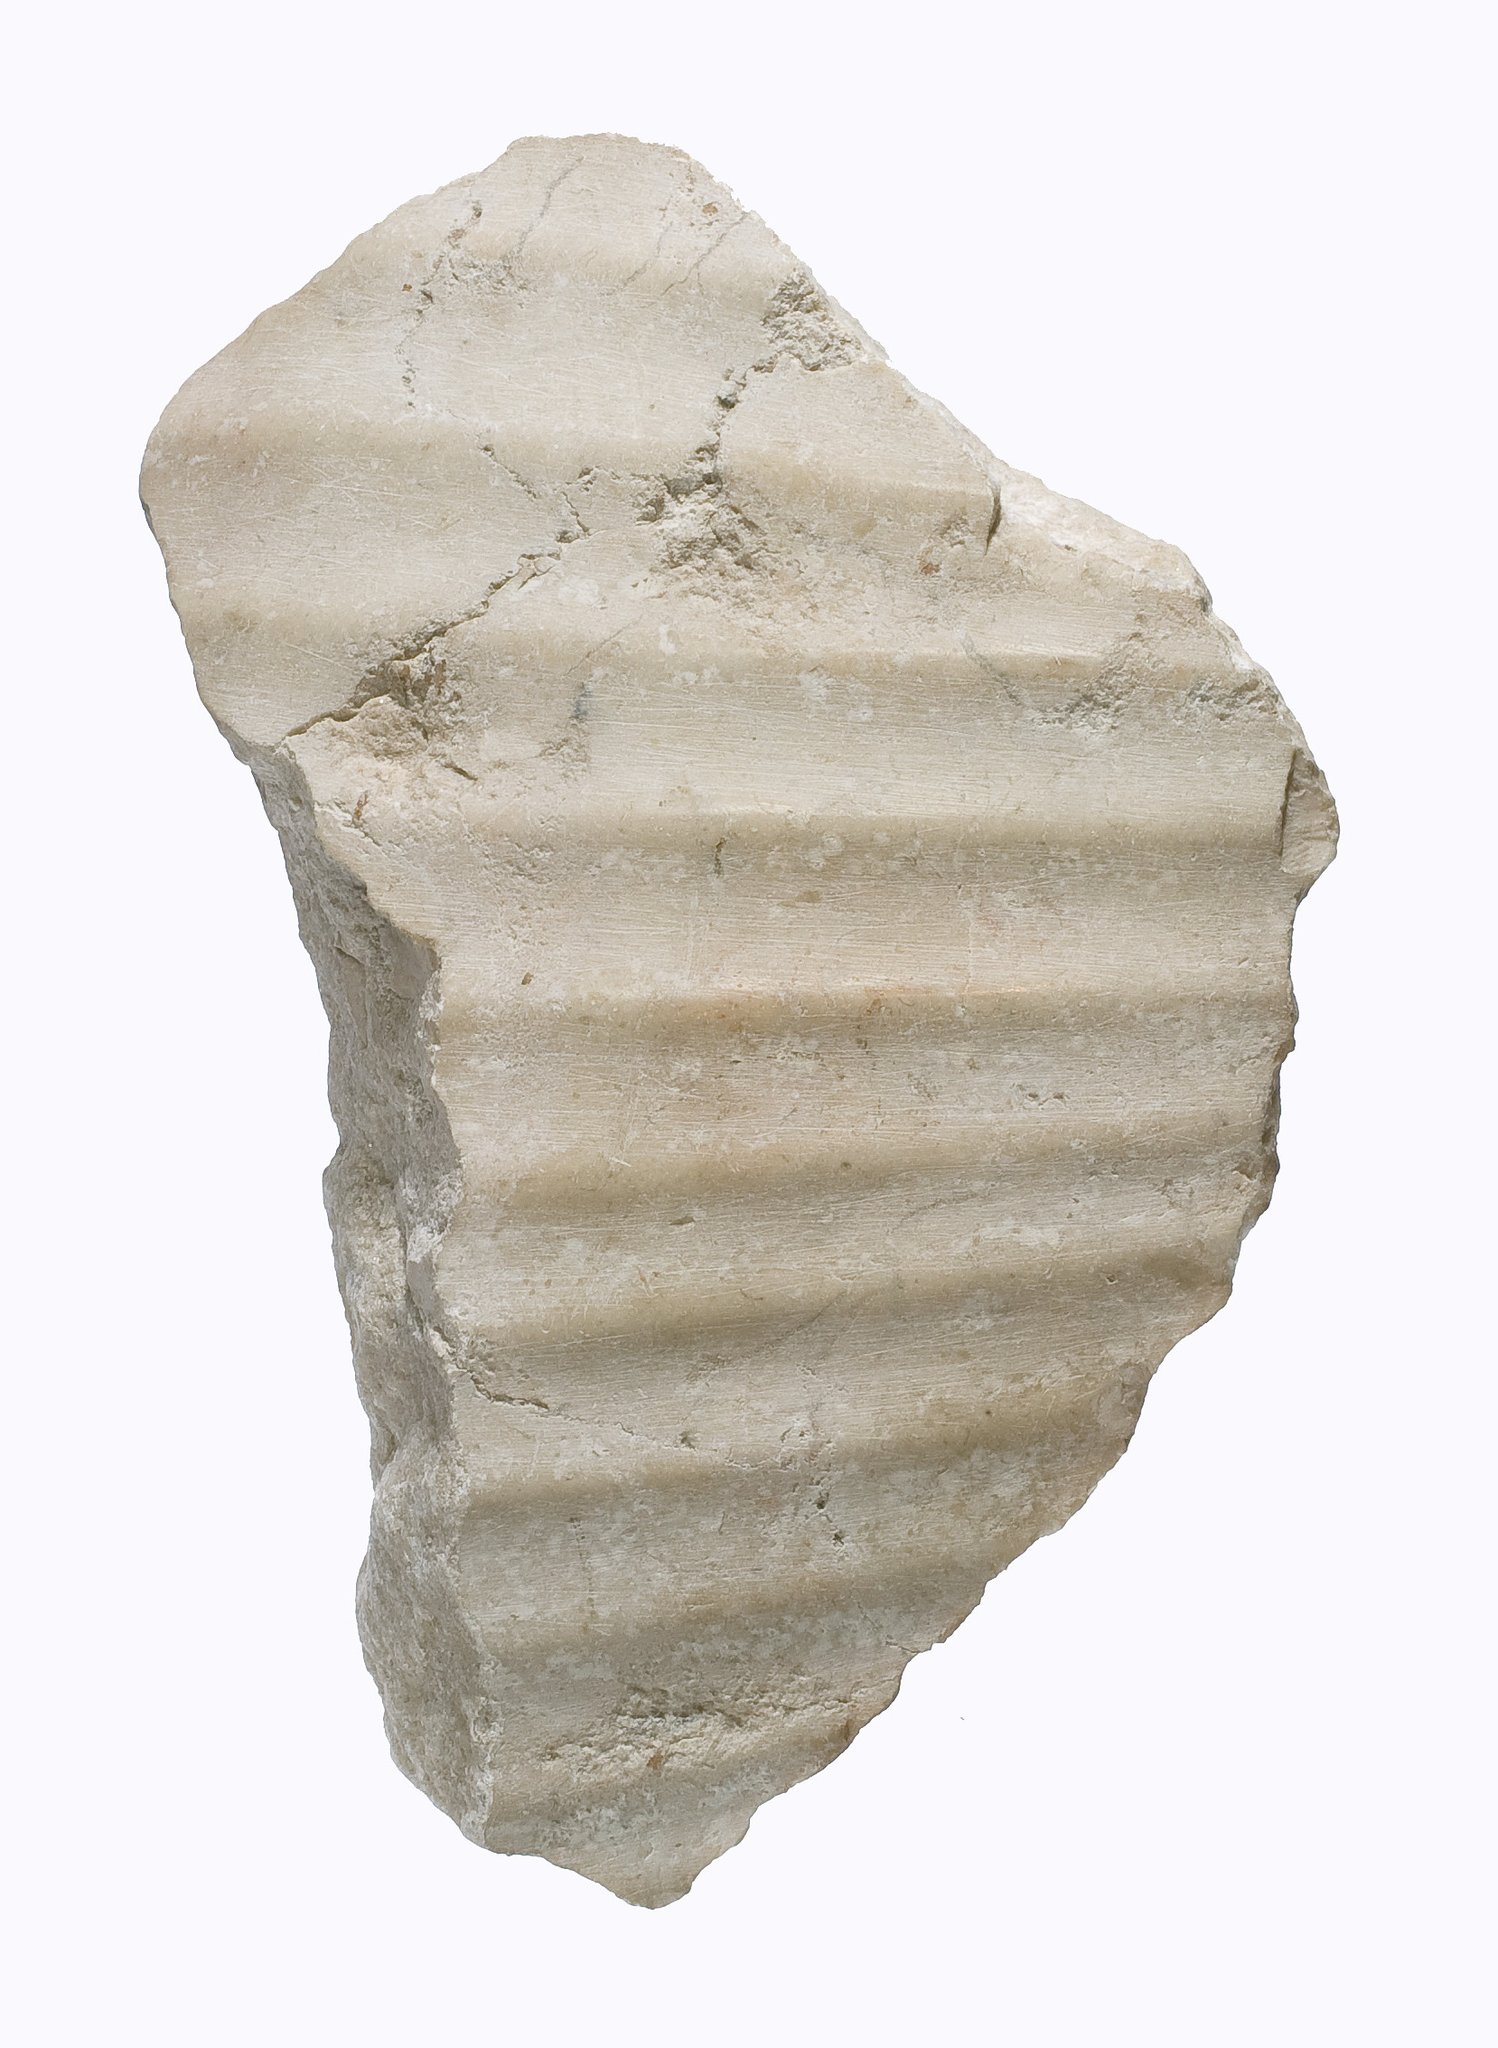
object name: body, gather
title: Body with kilt gathers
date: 1353-1336 BCE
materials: limestone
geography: egypt